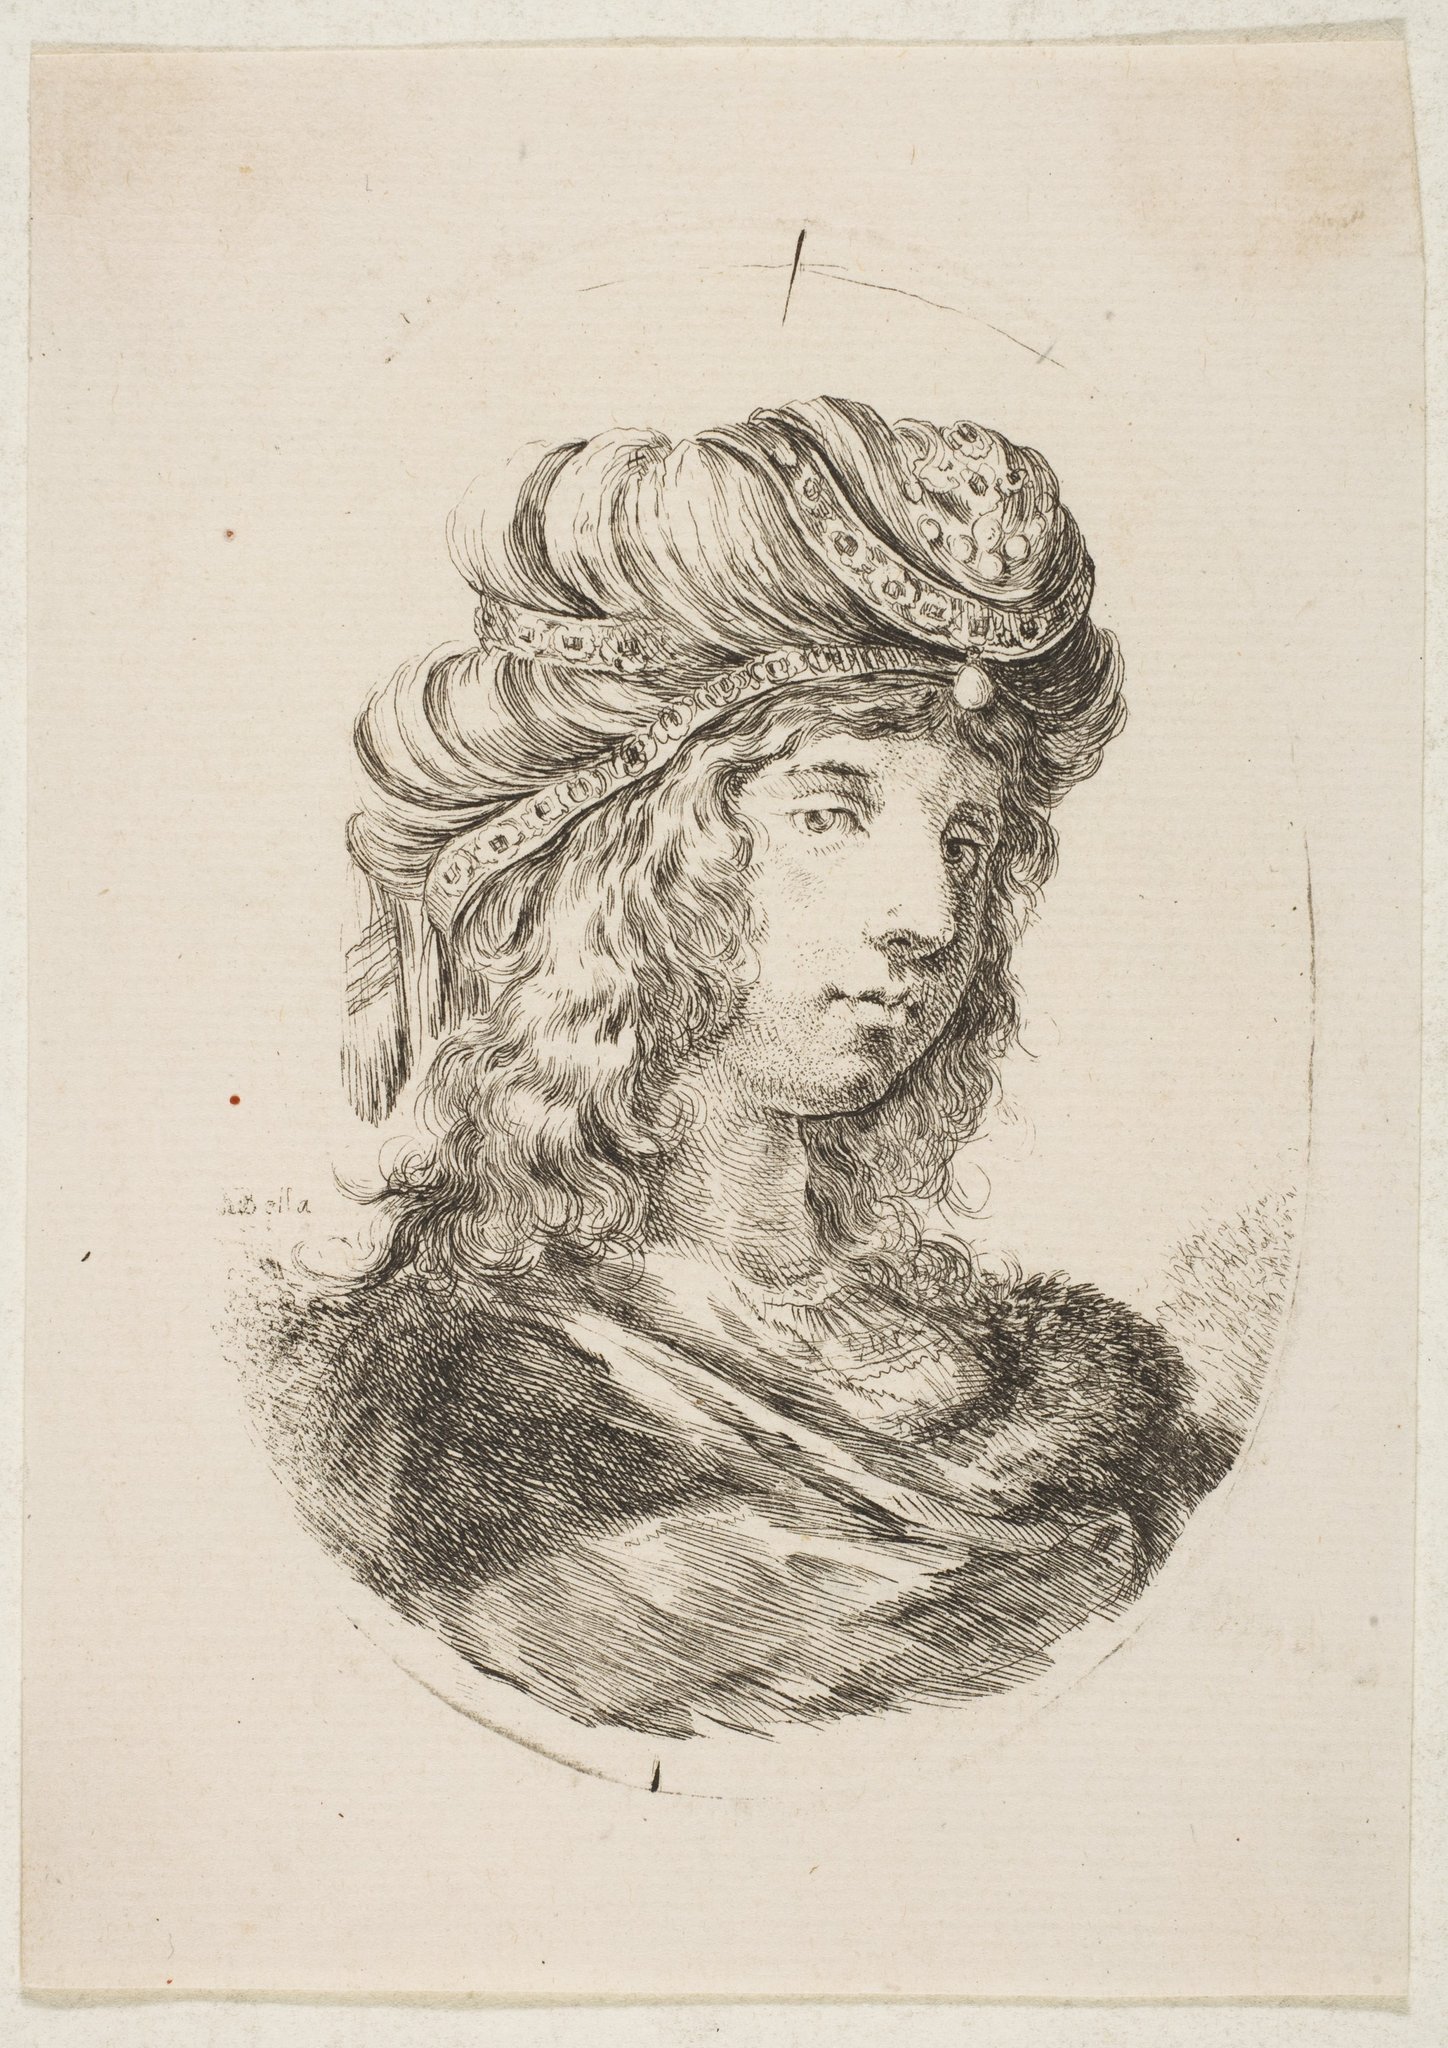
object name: print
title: Sultan wearing a fur and a turban, from 'Several heads in the Persian style' (Plusieurs têtes coiffées à la persienne)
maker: stefano della bella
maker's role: artist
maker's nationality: italian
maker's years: 1610-1664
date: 1649-1650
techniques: etching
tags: men,portraits